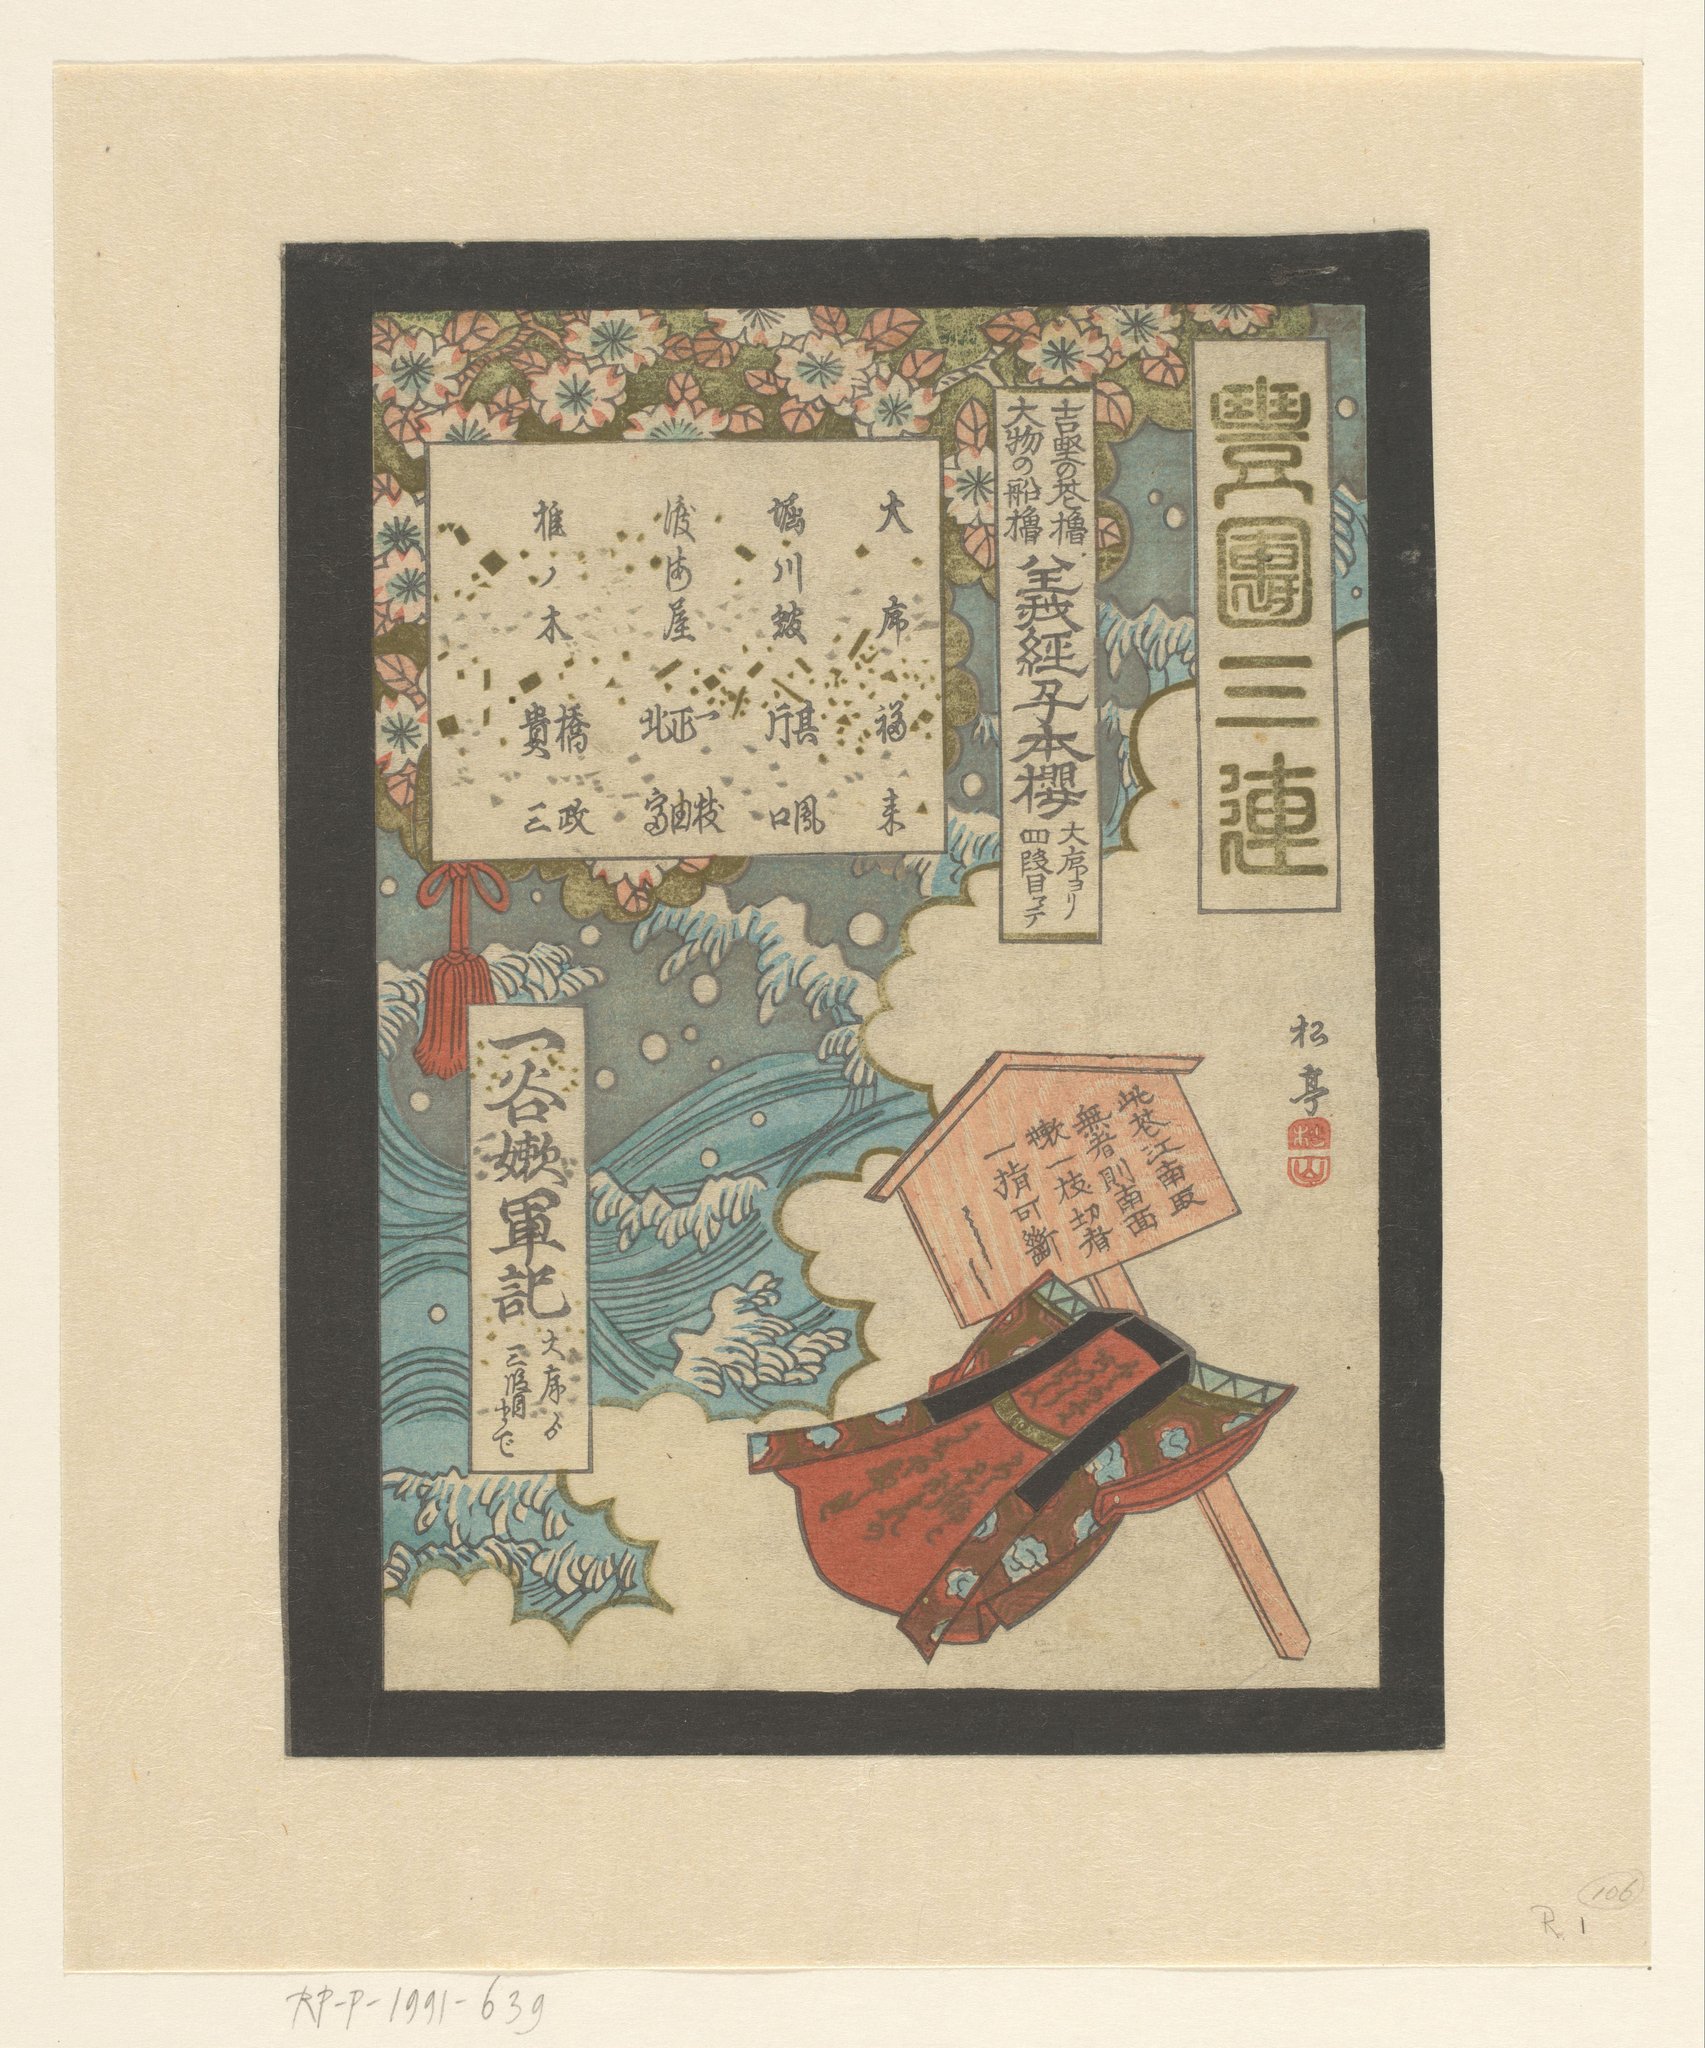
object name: print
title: Jasje, golven en bloesem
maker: shôtei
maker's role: print maker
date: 1890-1900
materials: paper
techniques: woodcut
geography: japan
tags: plants; vegetation (+ flowers, blossom, blossoming), tidal wave - hh - ideal landscapes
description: Op de achtergrond golven, bloesem en een kort jasje (jinbaori) dat over een harnas wordt gedragen. Deze prent is een uitnodiging voor twee kabuki toneelstukken genoemd: Yoshitsune senbonzakura en Ichinotani futabagunki. Met meedere teksten.